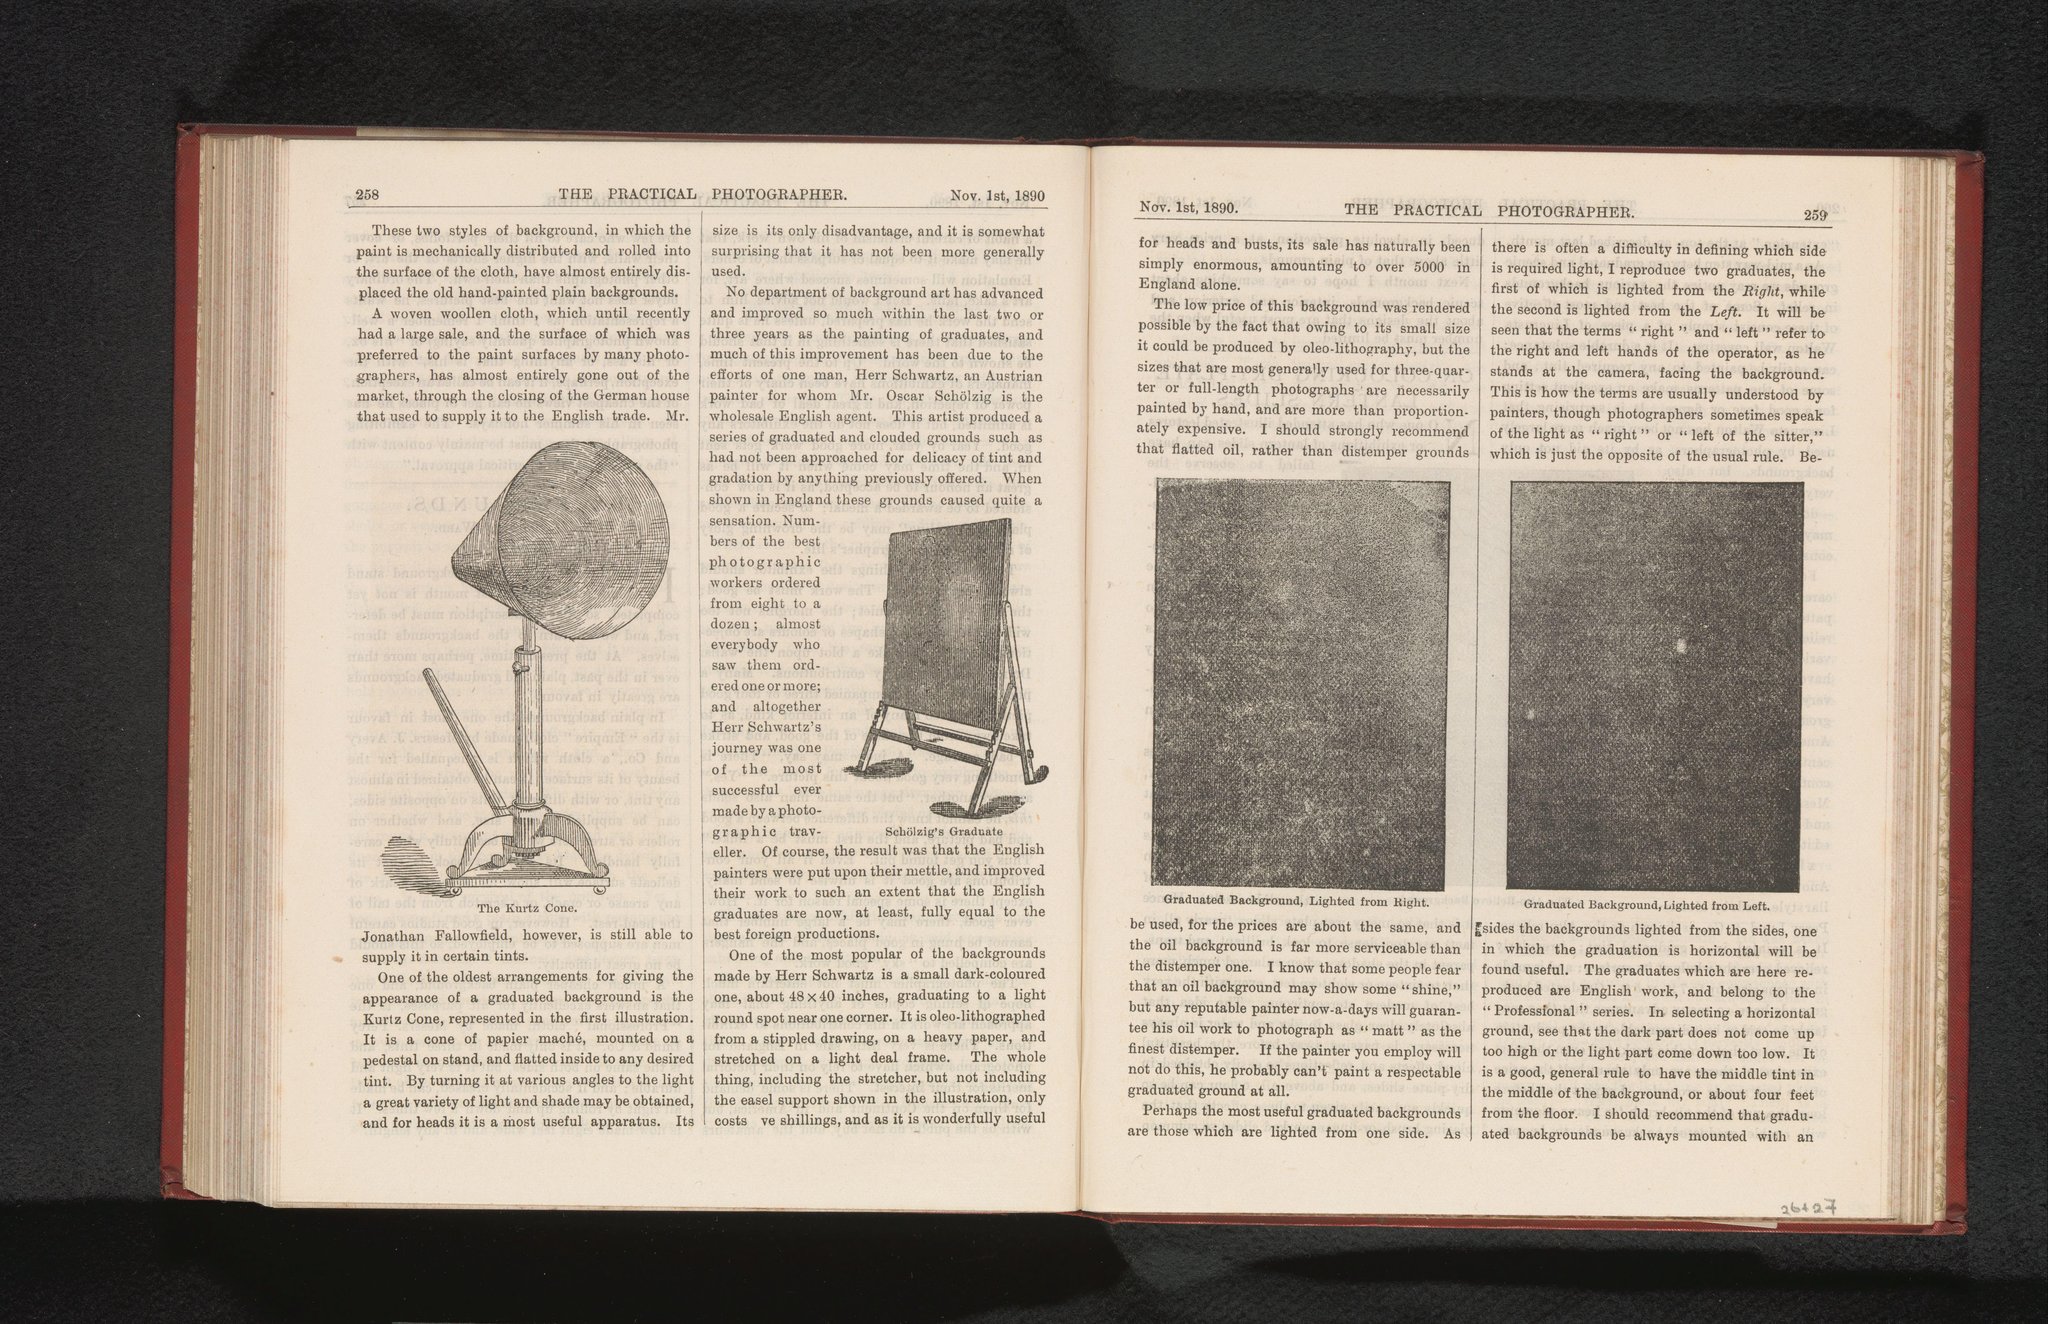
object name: photomechanical print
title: Graduated Background, Lighted from Right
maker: Anonymous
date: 1885-1890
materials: paper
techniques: autotype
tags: photography